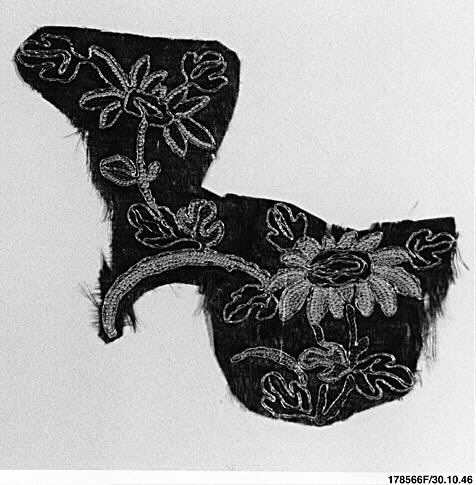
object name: piece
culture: chinese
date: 1801-1900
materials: metal thread, silk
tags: flowers